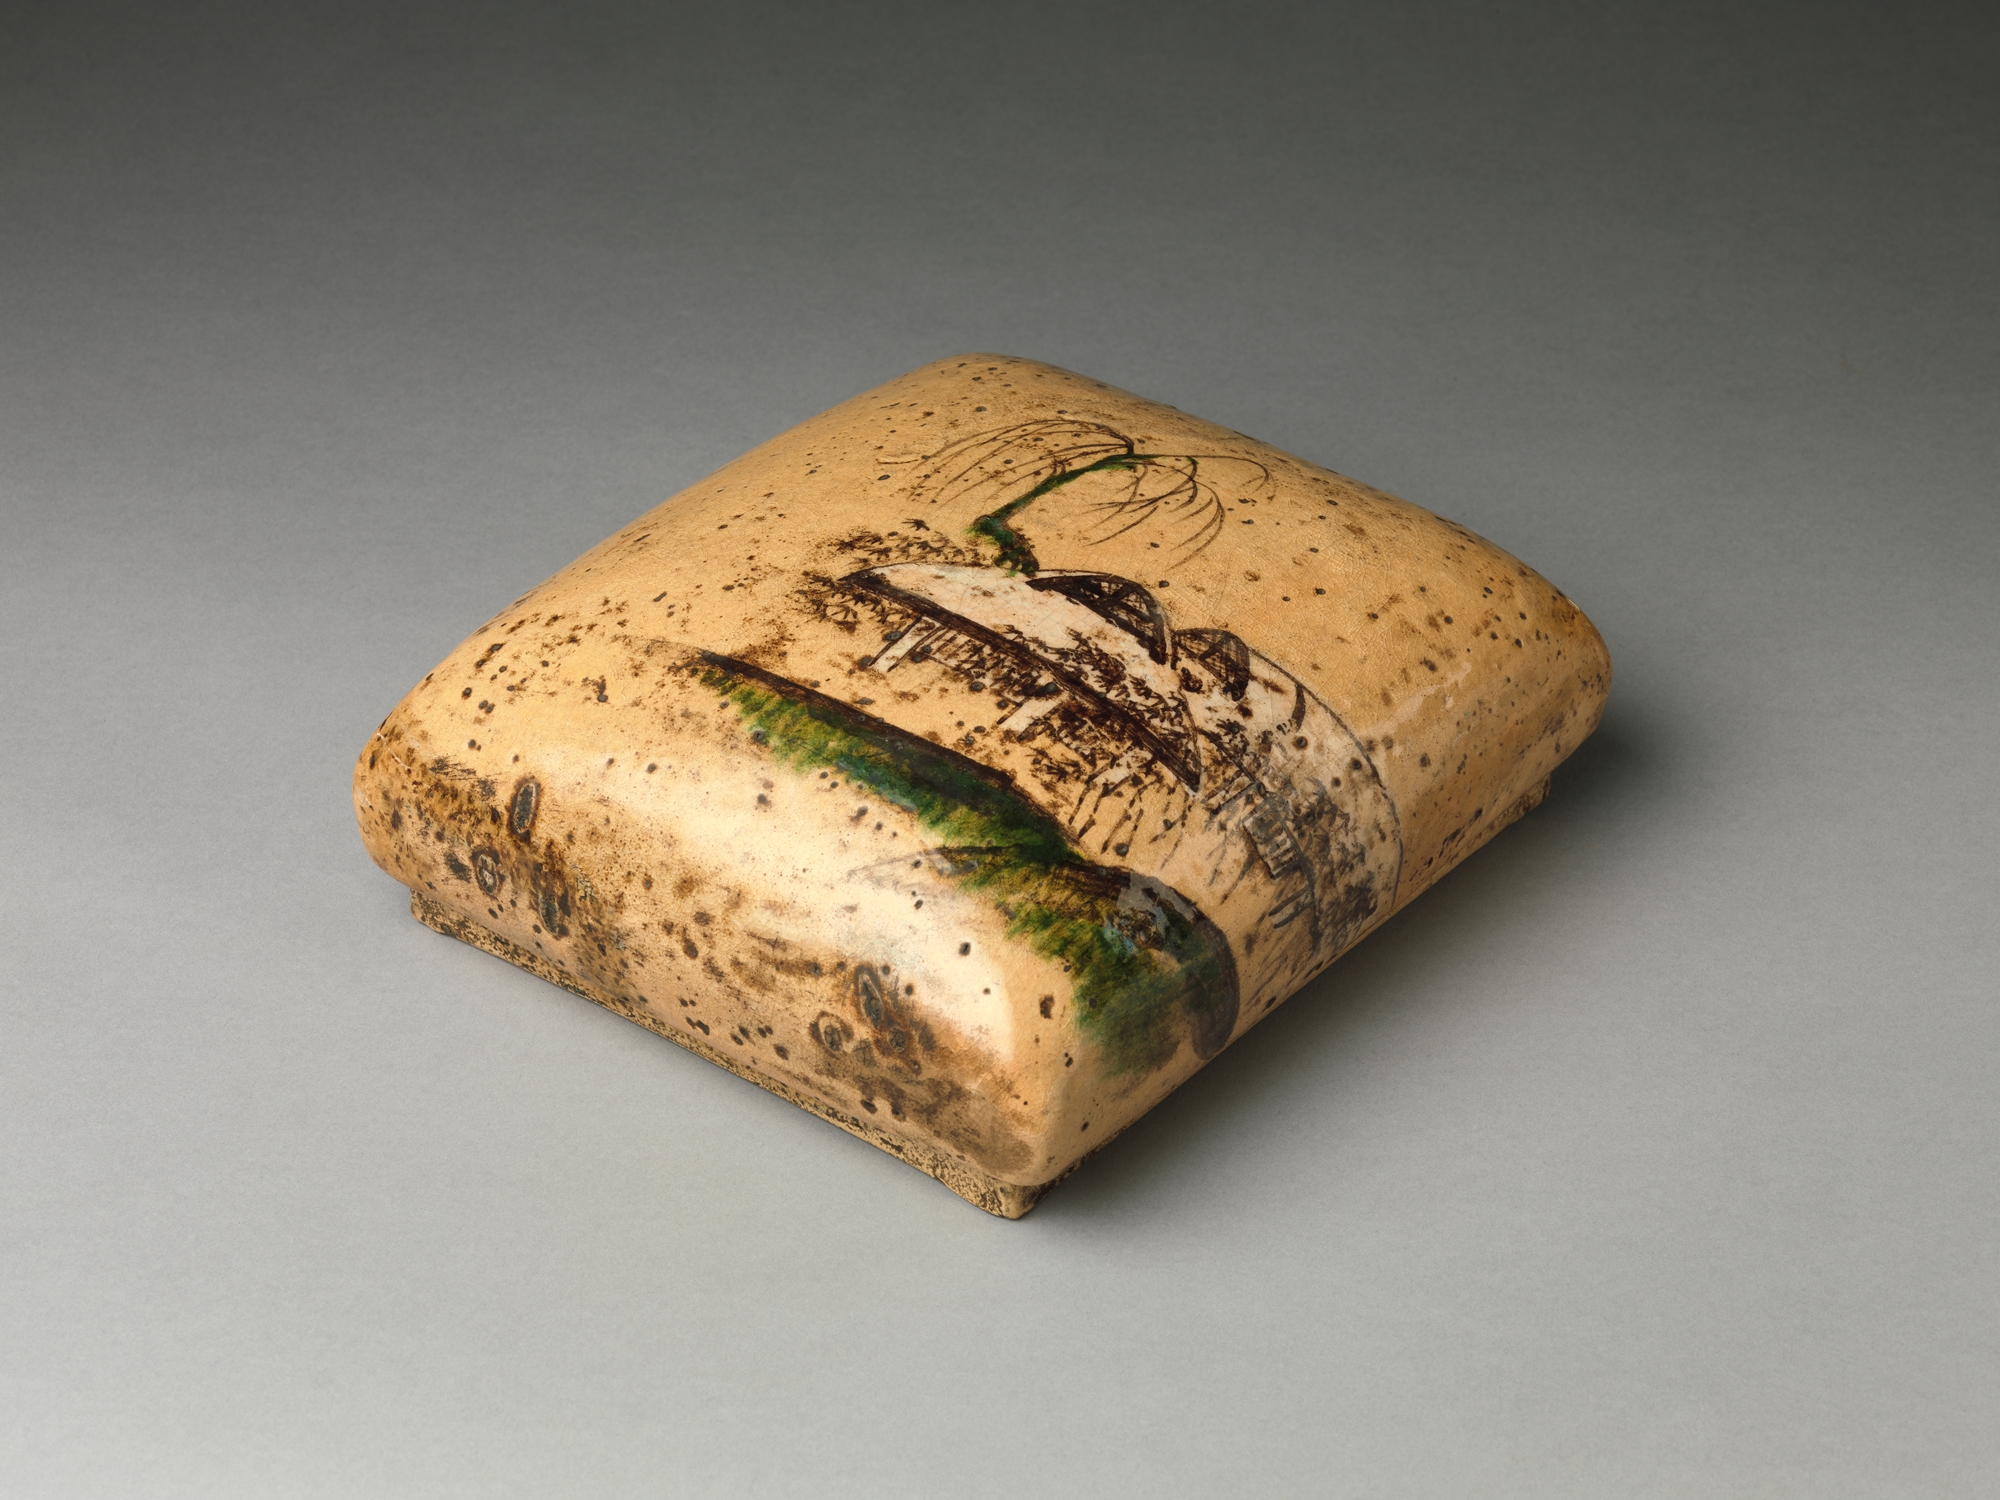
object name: writer's box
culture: japanese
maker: ogata kenzan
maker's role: artist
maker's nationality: japanese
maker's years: 1663-1743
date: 1615-1868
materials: clay, glaze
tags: houses,trees